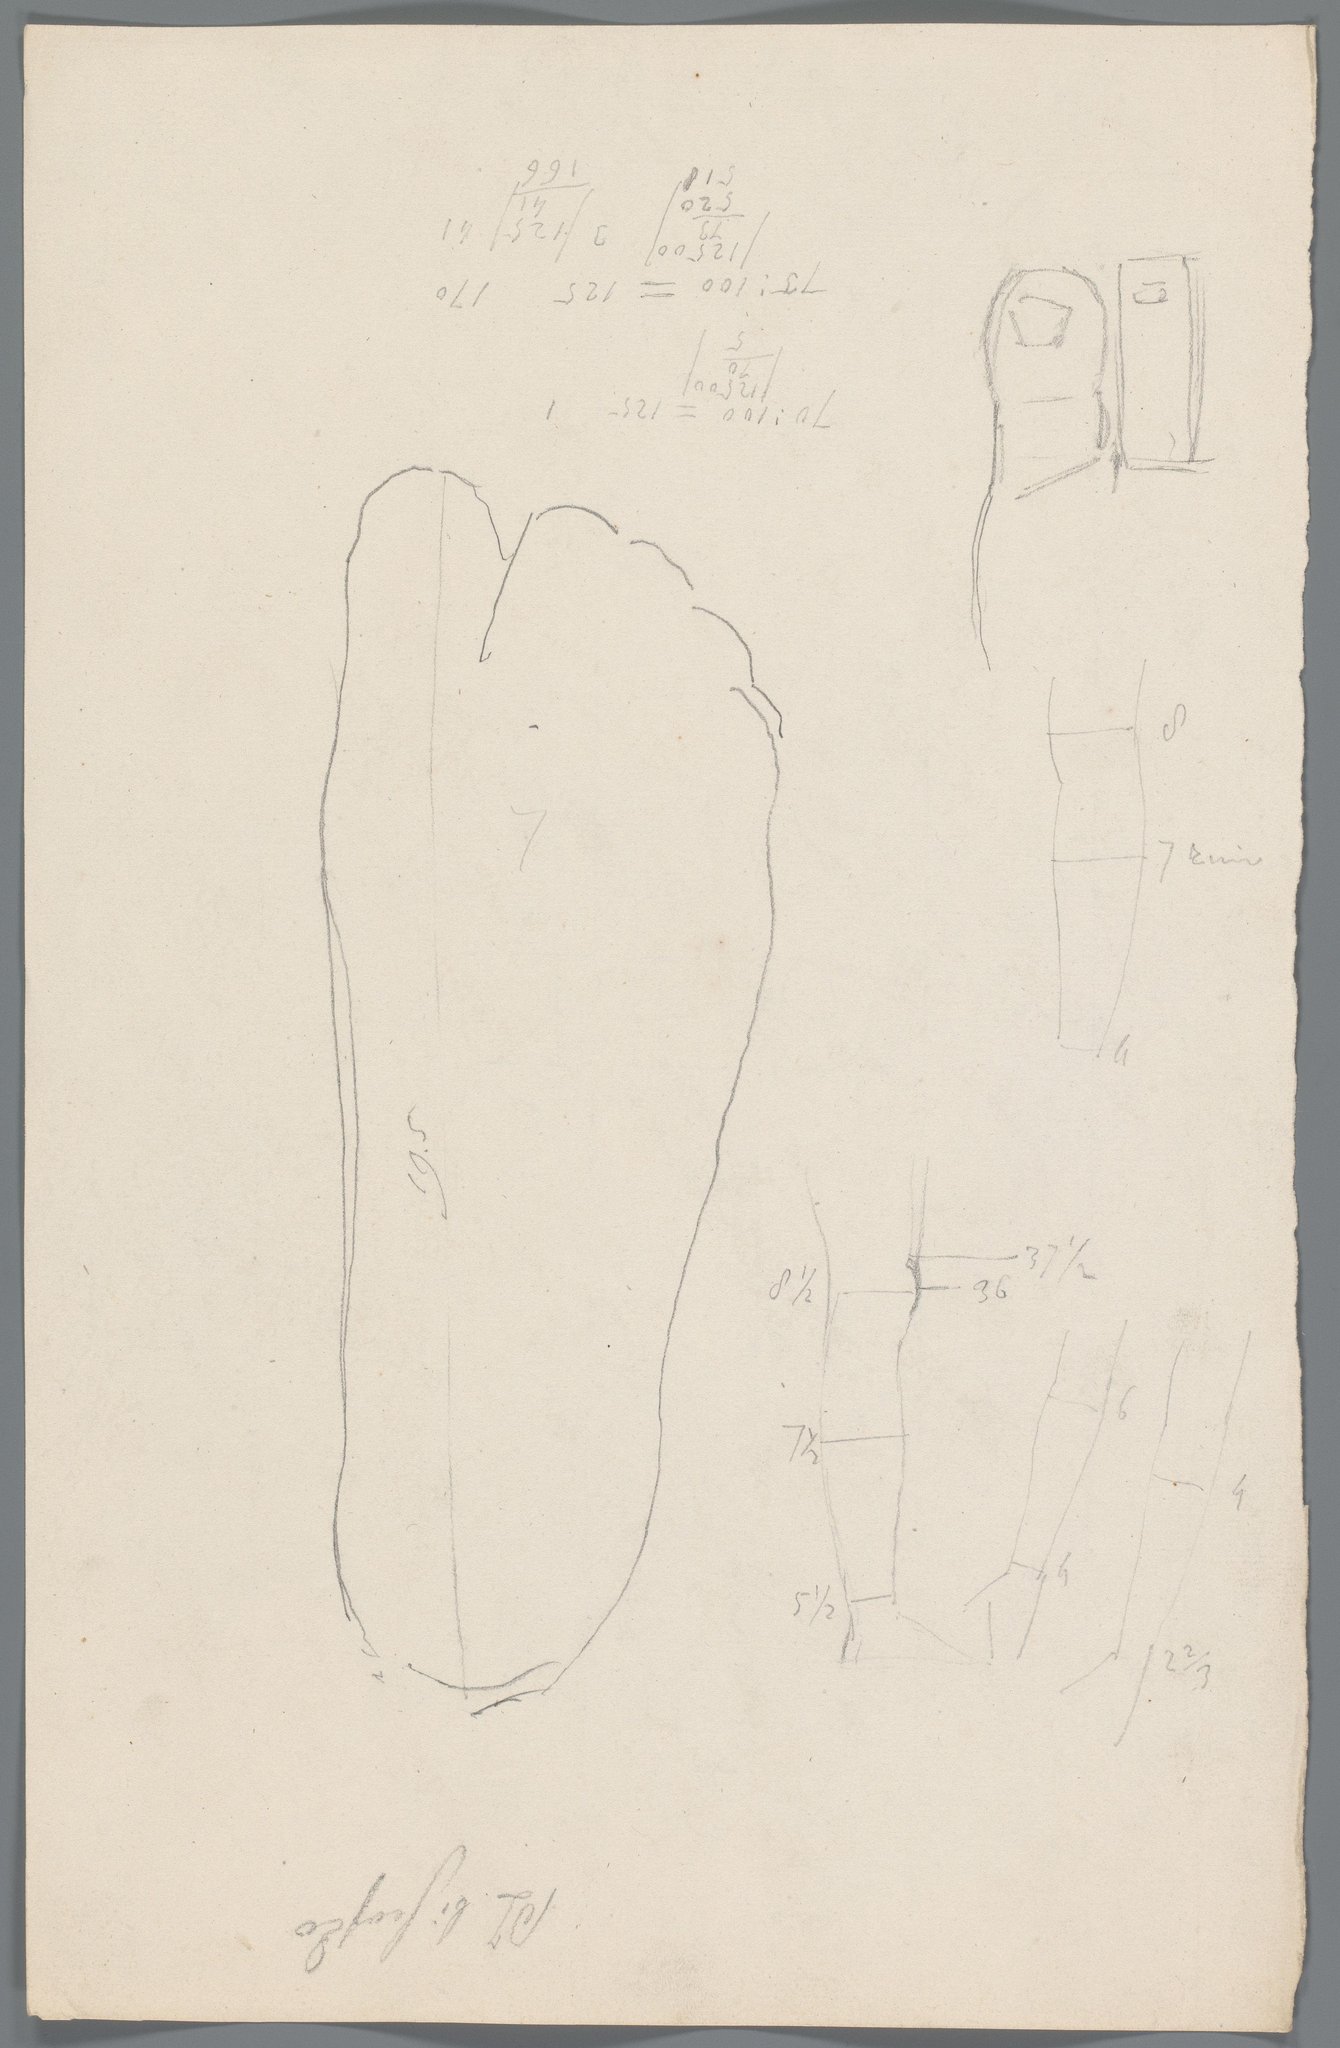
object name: drawing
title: Omtrek van een voet en studies van armen en benen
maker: jacobus everhardus josephus van den berg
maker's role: draughtsman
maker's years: 1802-1861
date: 1812-1861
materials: paper, pencil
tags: arms, foot, legs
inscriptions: inscription